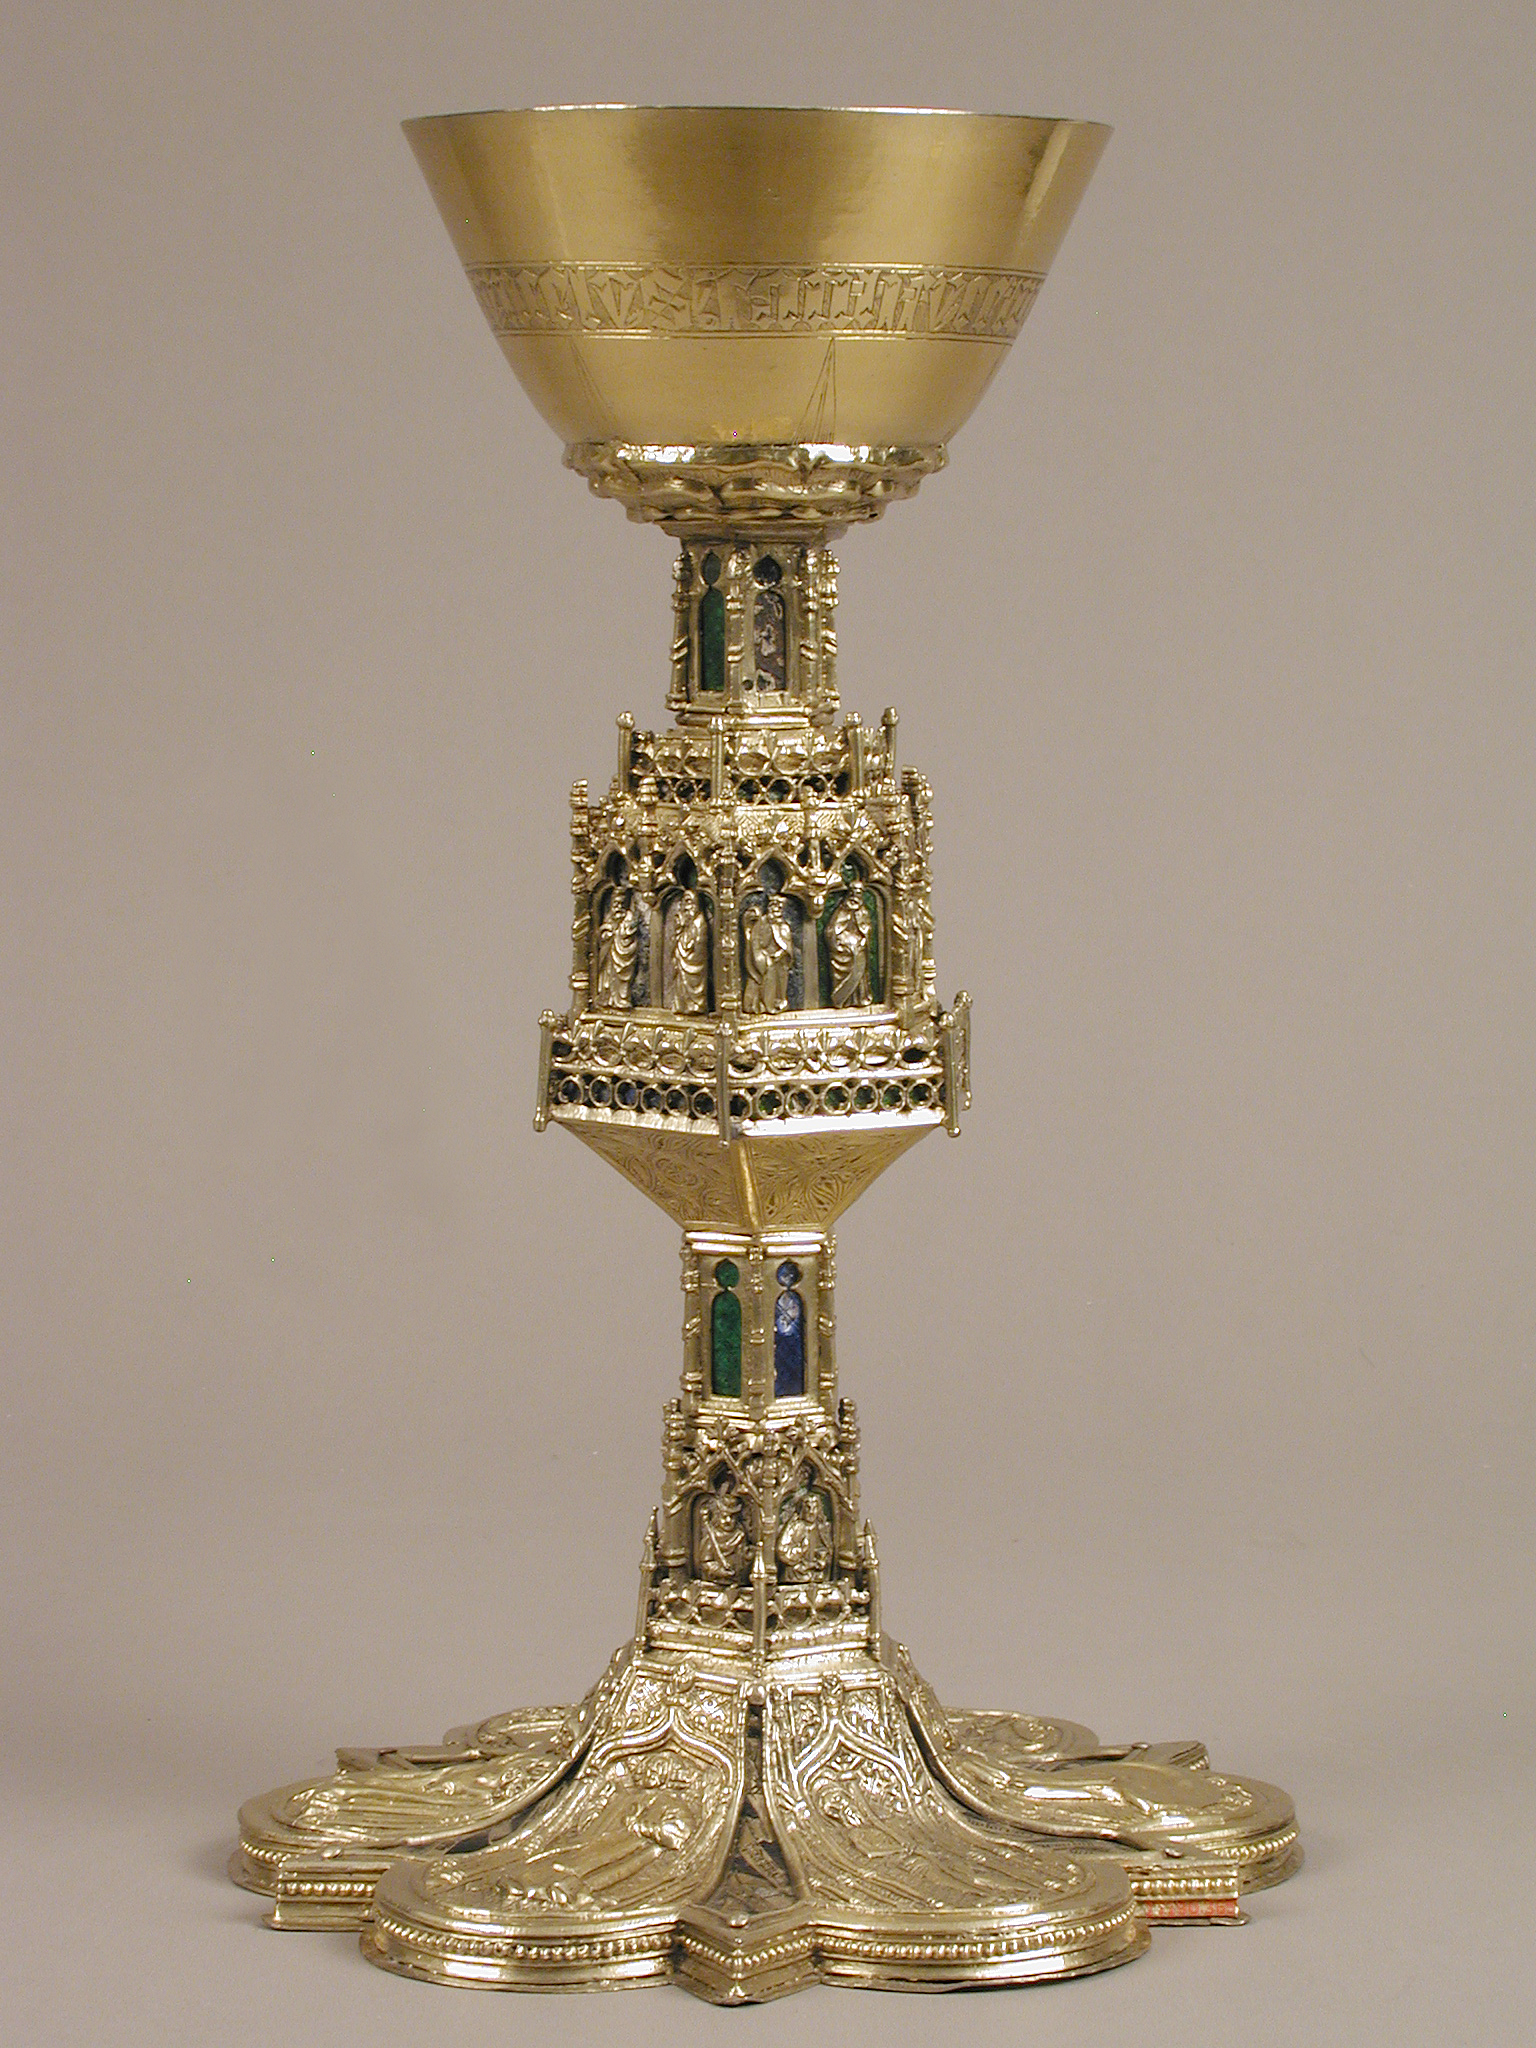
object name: chalice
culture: spanish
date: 1401-1500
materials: enamel, silver gilt